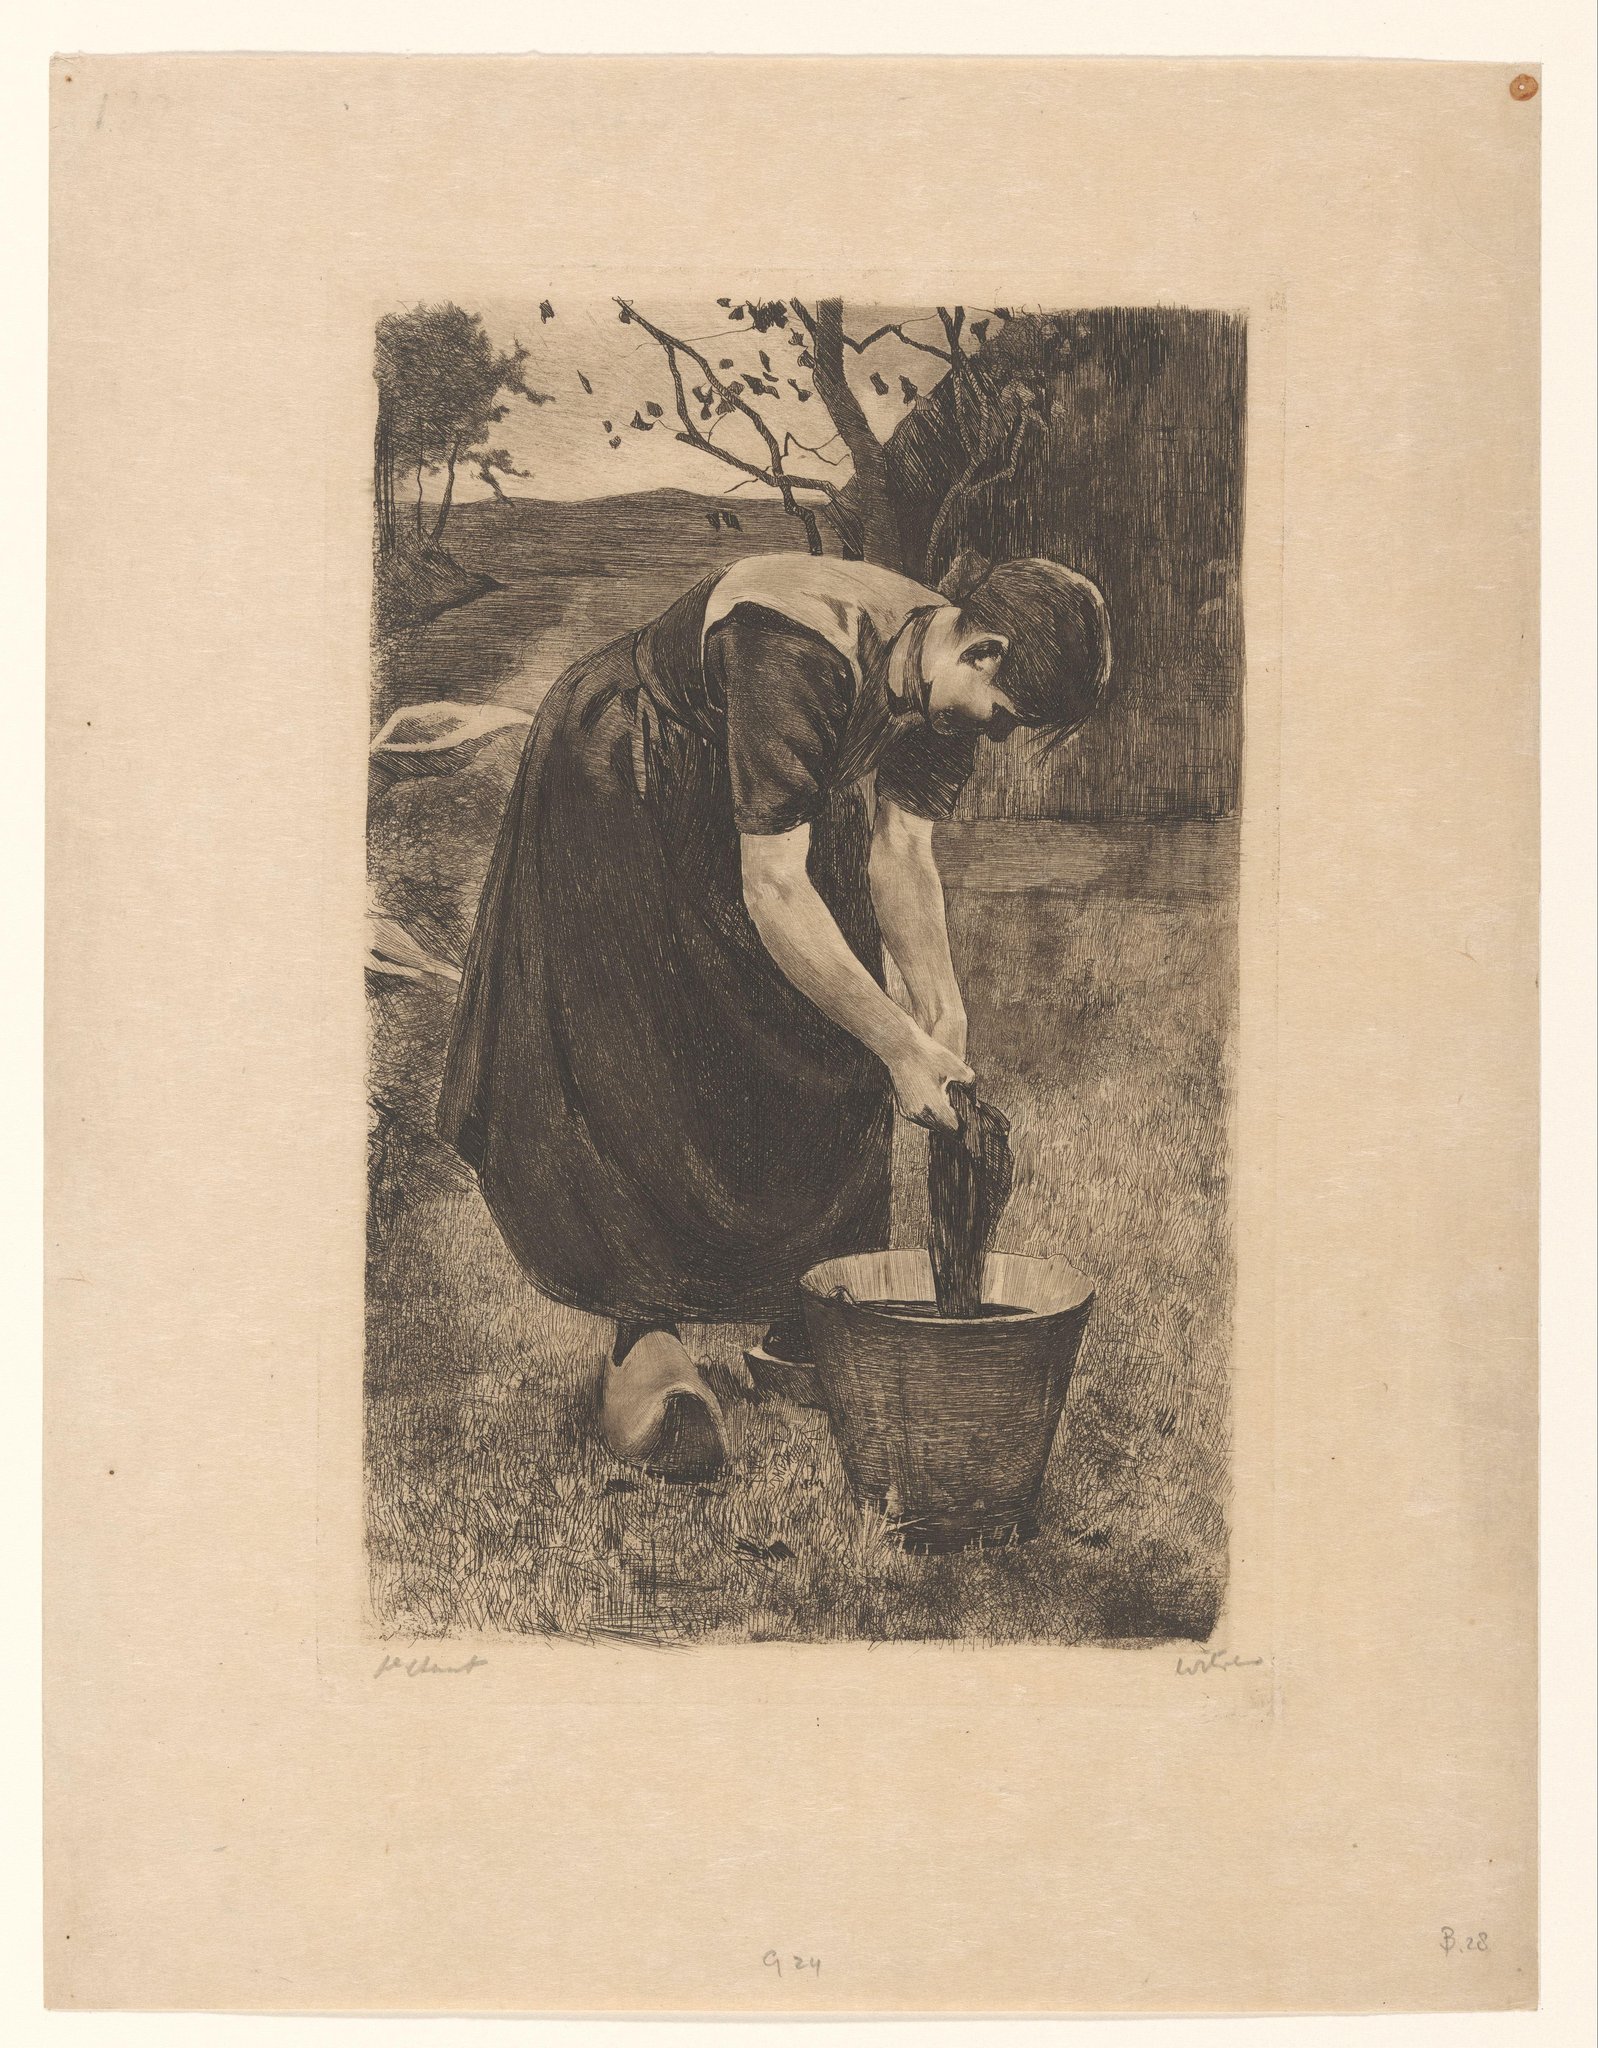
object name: print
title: Boerin wast textiel in een emmer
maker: willem witsen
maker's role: draughtsman, painter, print maker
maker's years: 1860-1923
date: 1886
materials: paper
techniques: drypoint, etching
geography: ewijkshoeve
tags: farmers - aa - female farmer, farmer's wife, washing up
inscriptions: signature: ‘Witsen’, collector's mark: Lugt 2228, inscription: ‘1e staat’